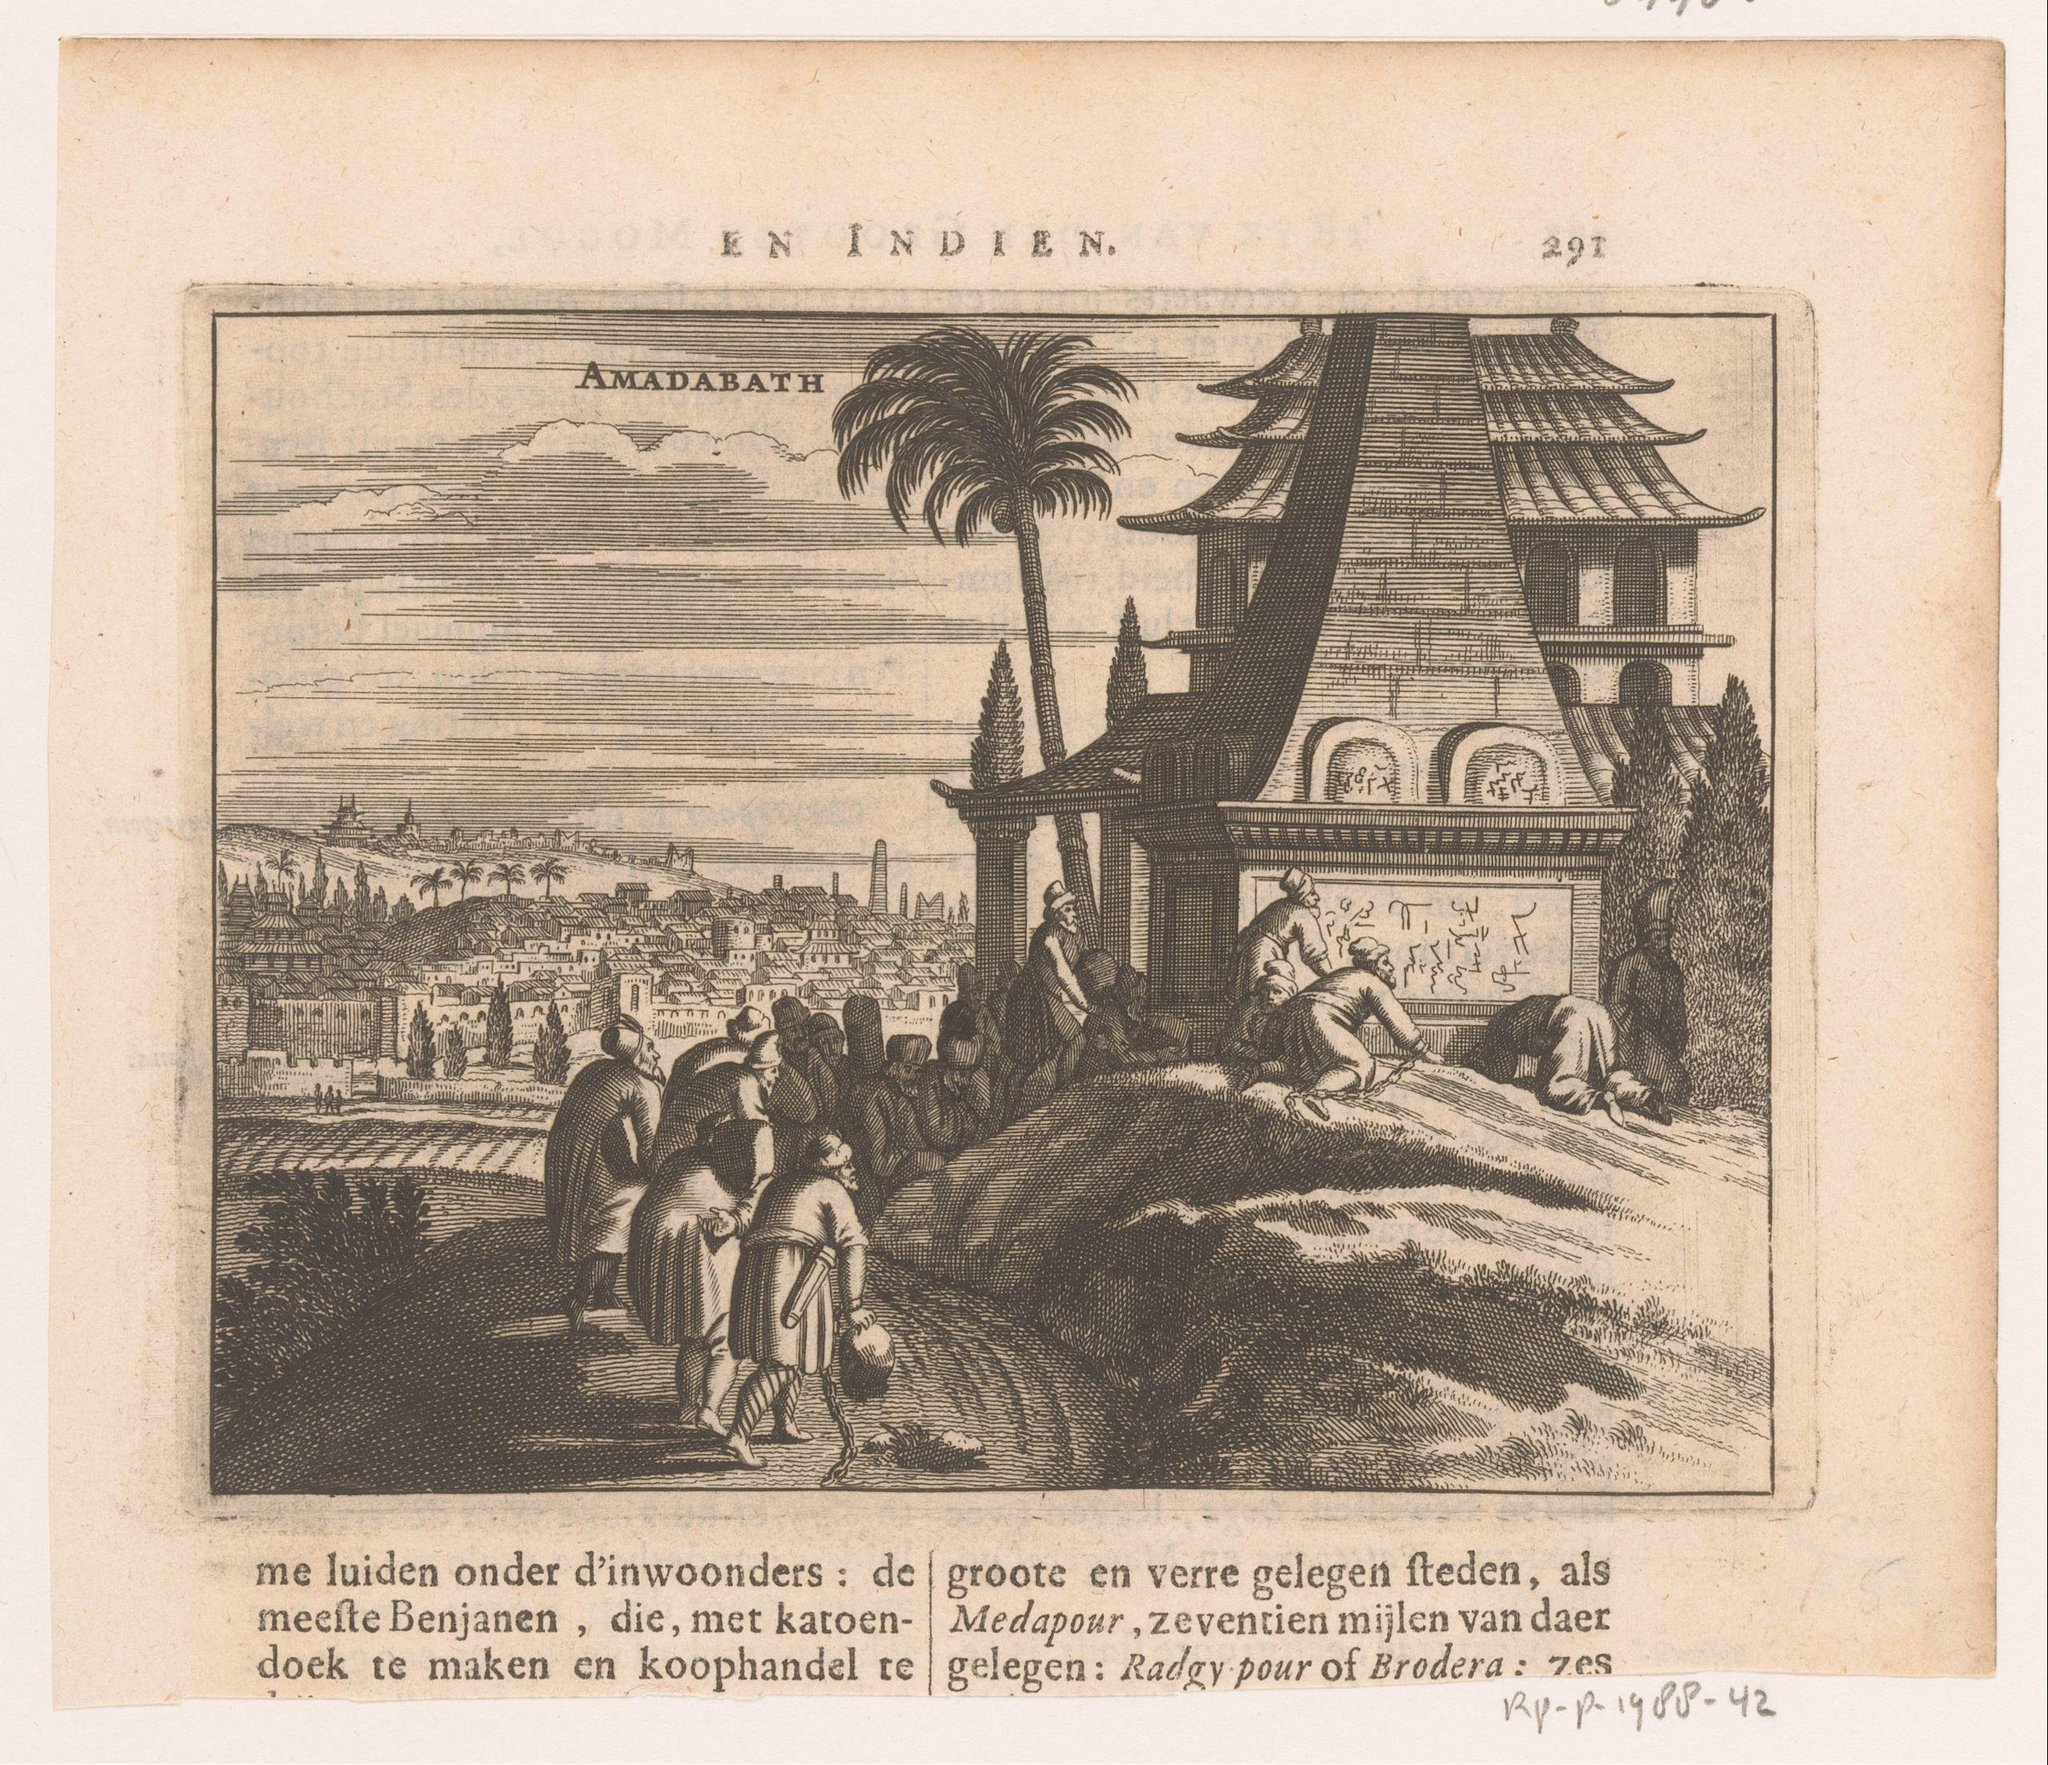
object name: print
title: Gezicht op een monument en de stad Ahmedabad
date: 1672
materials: paper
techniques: engraving, etching, letterpress printing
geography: amsterdam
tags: grave-building, monumental tomb, prospect of city, town panorama, silhouette of city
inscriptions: collector's mark: Lugt 2228, collector's mark: Lugt 2760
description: Prent uit: Dapper, Olfert. Asia, of naukeurige beschryving van het rijk des grooten Mogols (...). Amsterdam: Jakob van Meurs, 1672, p. 291.